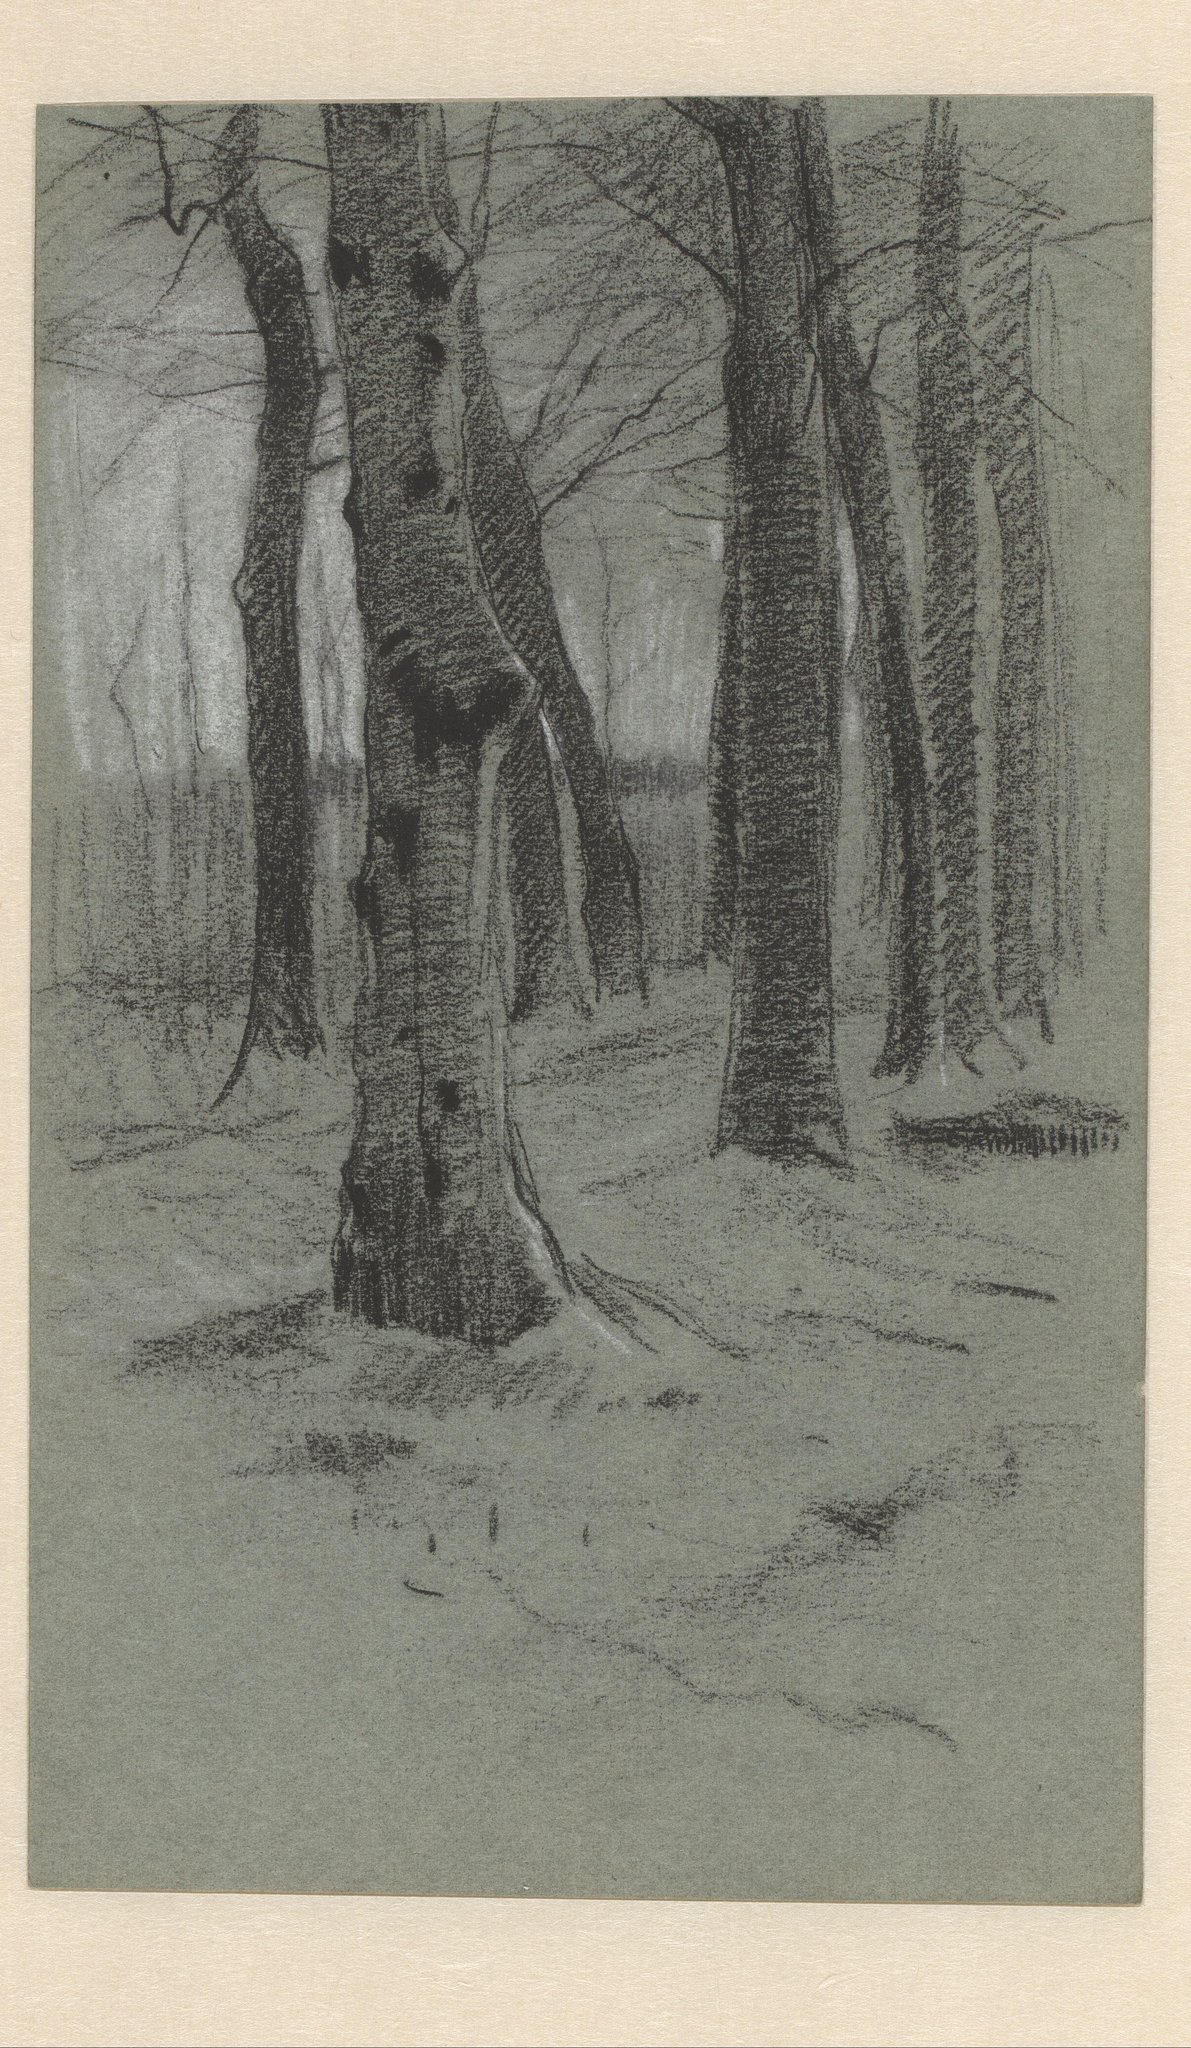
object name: drawing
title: Bomengroep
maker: willem witsen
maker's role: draughtsman, painter, print maker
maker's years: 1860-1923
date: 1870-1923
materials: chalk, paper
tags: forest, wood